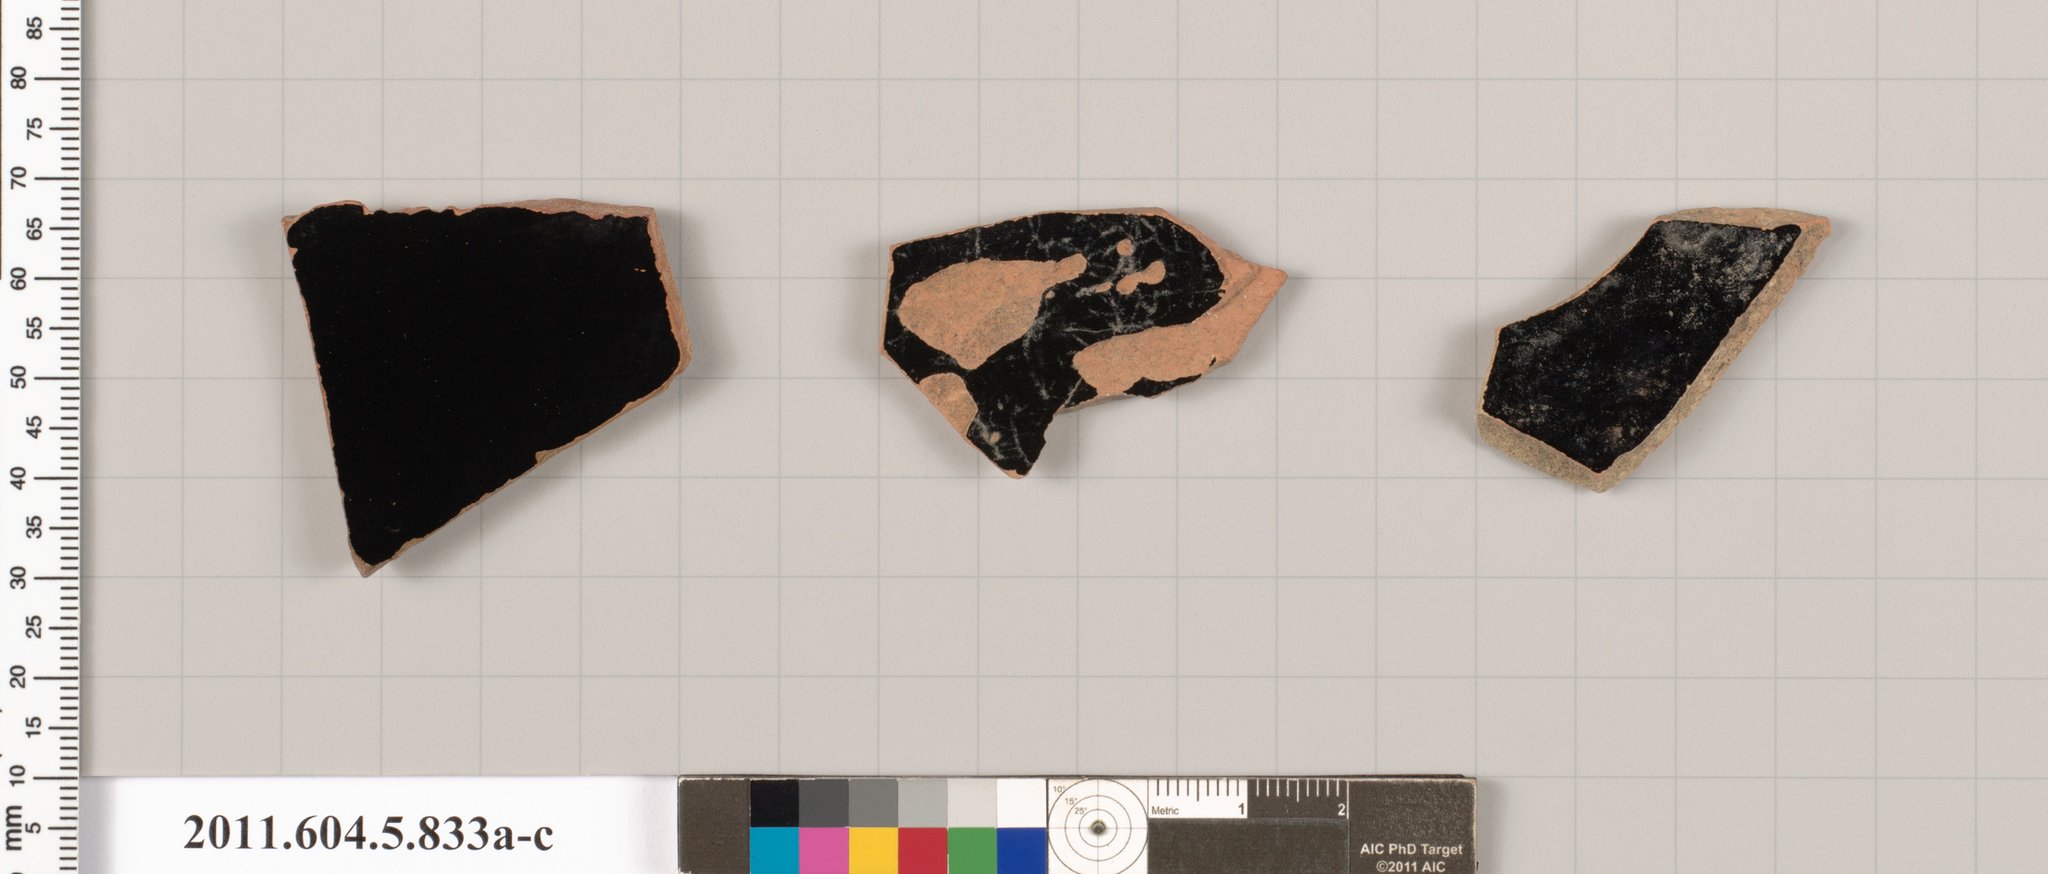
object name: kylix fragment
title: Terracotta fragments of kylikes (drinking cups)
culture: greek, attic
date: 600-401 BCE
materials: terracotta